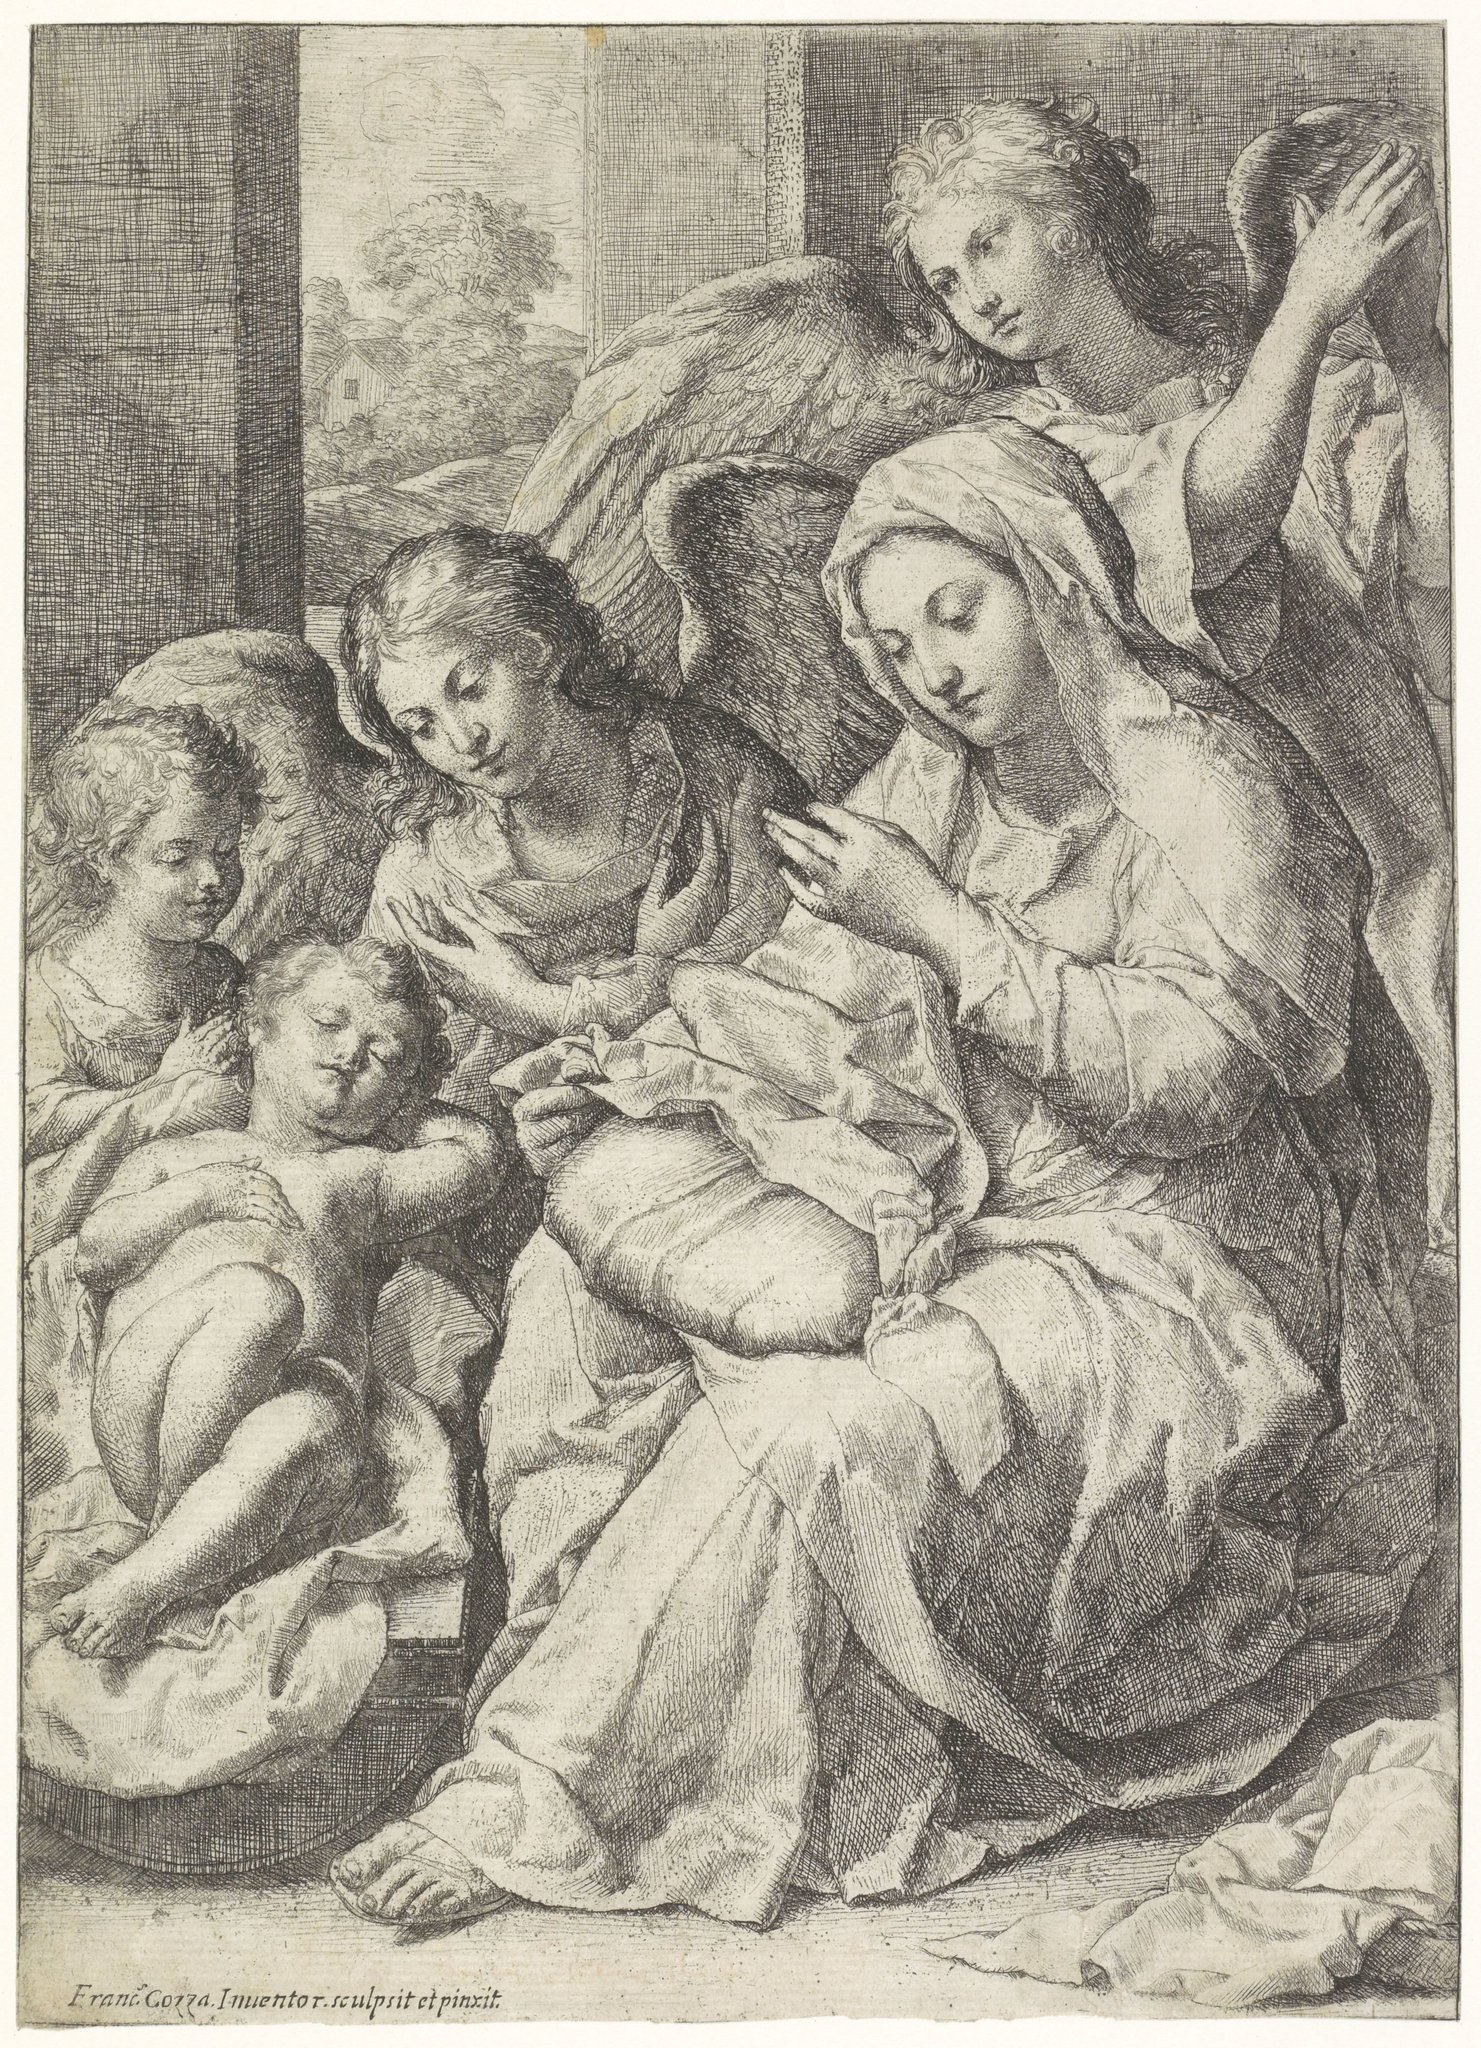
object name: print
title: Maria en het slapende Christuskind omgeven door engelen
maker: francesco cozza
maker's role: print maker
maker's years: 1605-1682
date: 1615-1682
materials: paper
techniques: etching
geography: italy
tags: madonna: i.e. mary with the christ-child, sleeping; unconsciousness, angels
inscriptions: collector's mark: Lugt 2228, collector's mark: Lugt 2760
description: Maria zit rechts. Christus slaapt op de voorgrond links. Achter hen staan drie engelen.